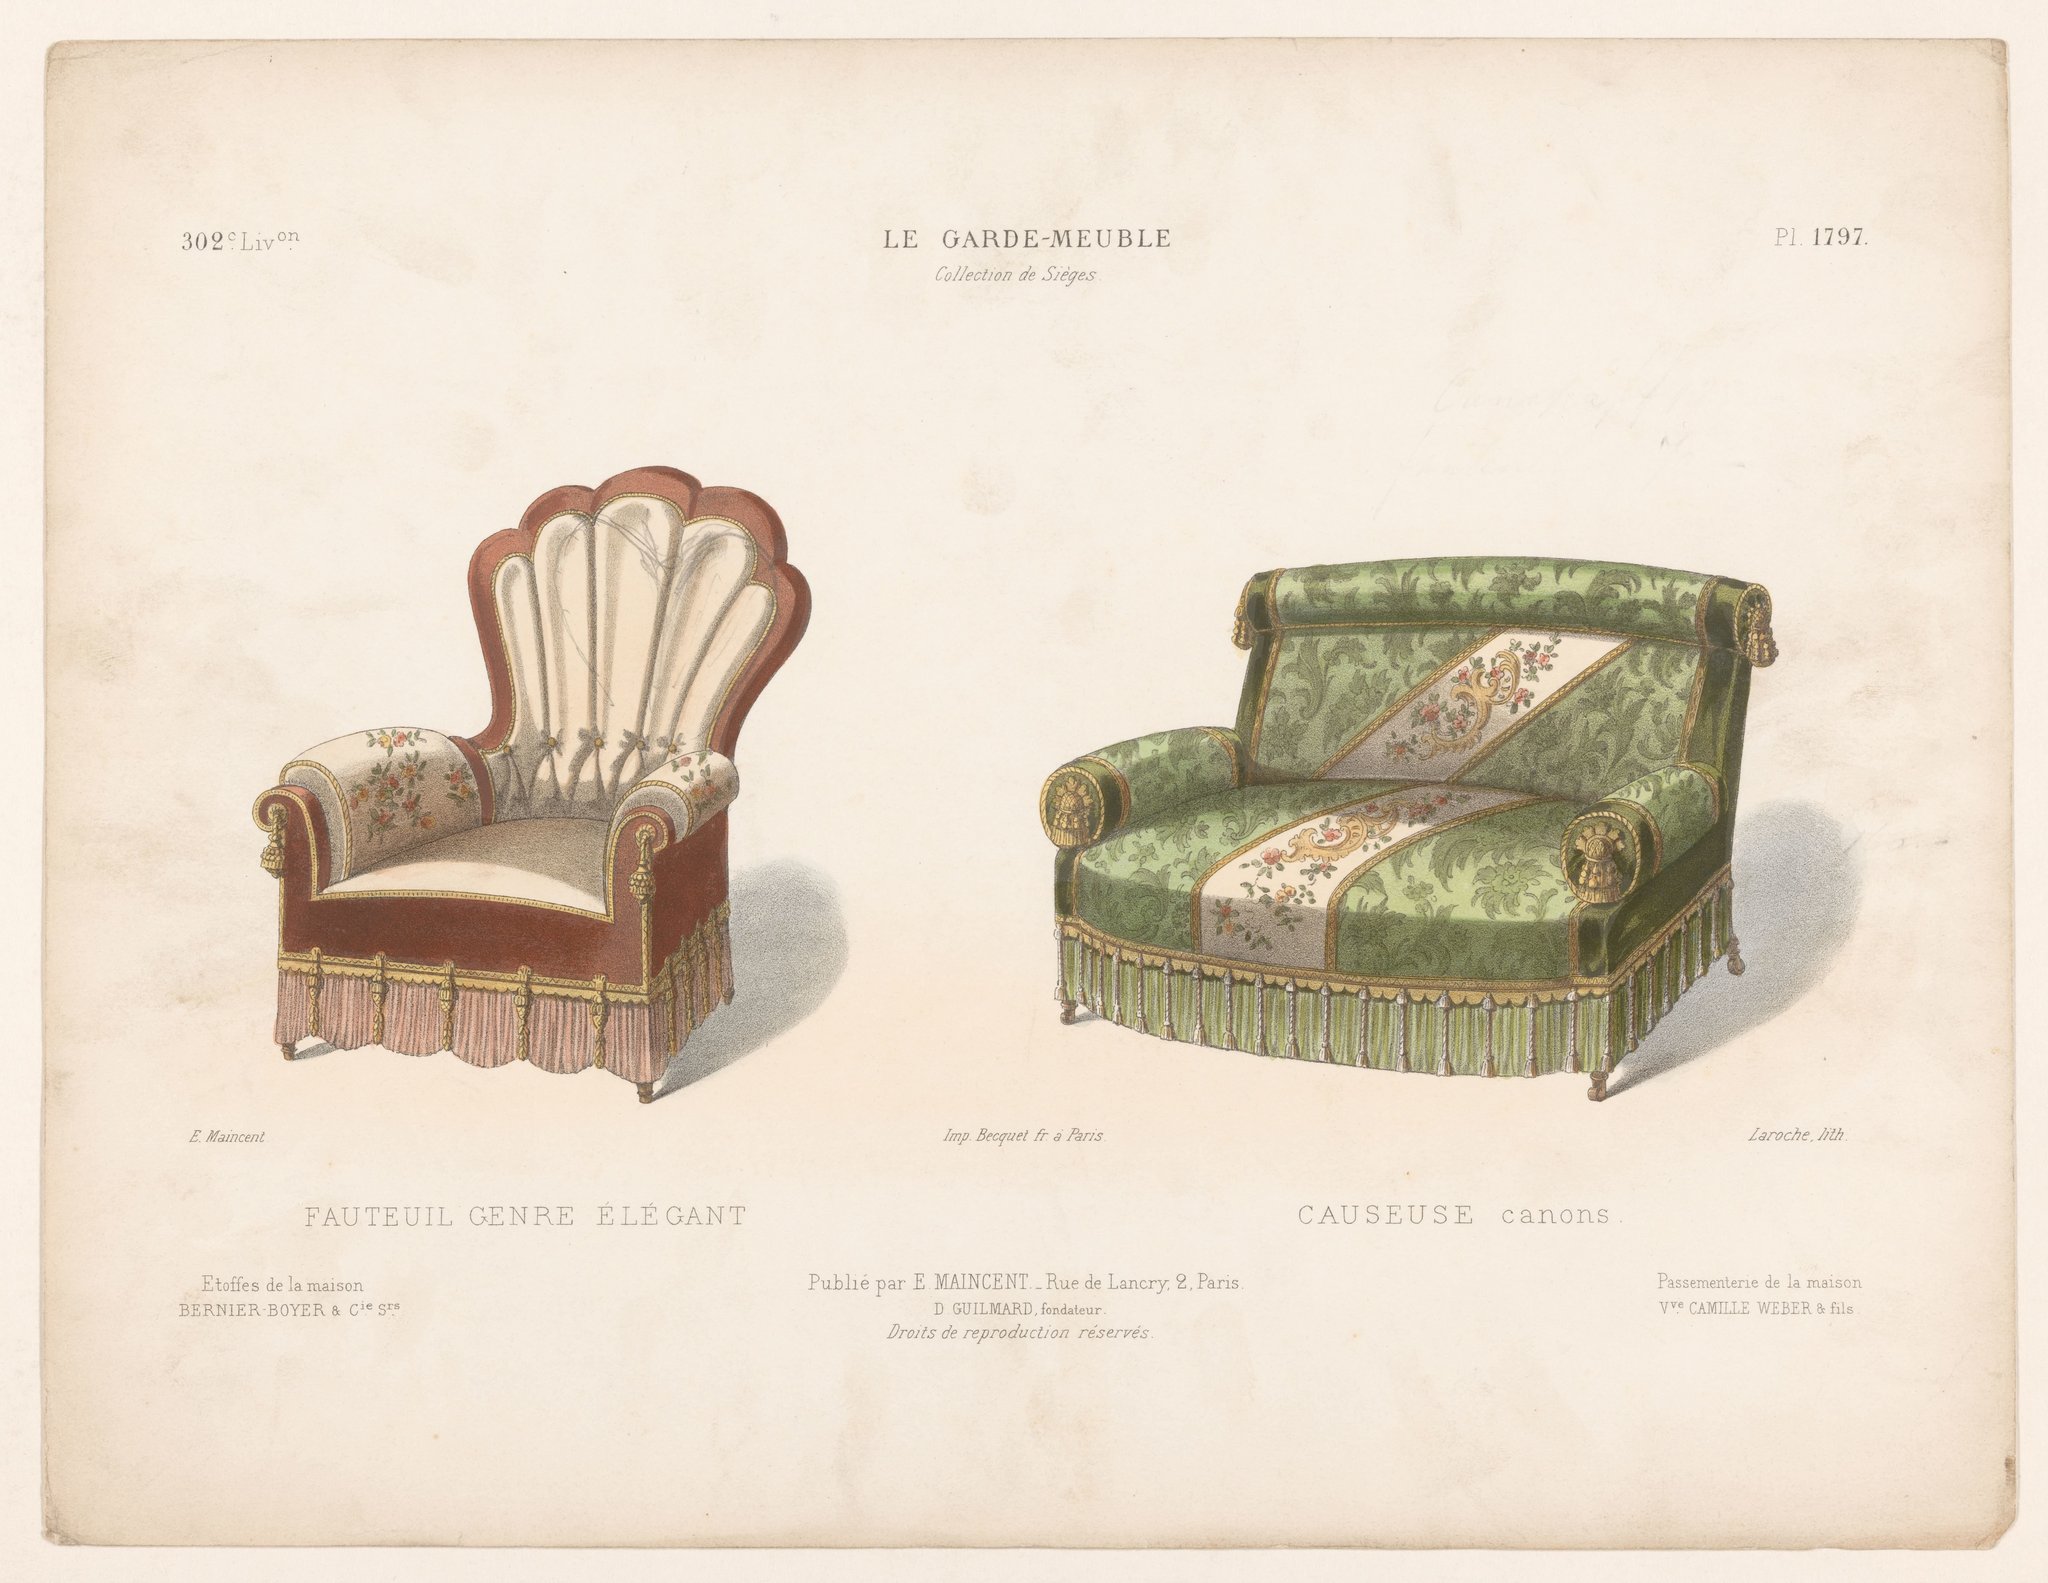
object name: print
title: Fauteuil genre élégant / Causeuse canons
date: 1885-1895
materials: paper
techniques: hand coloring, lithograph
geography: paris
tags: seating furniture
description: Ieder Livraison in de serie Le Garde-Meuble bevat negen platen: drie 'sièges' (zitmeubels), drie 'meubles' (diverse meubels zoals tafels en kasten) en drie 'tentures' (gordijnen en draperieën).